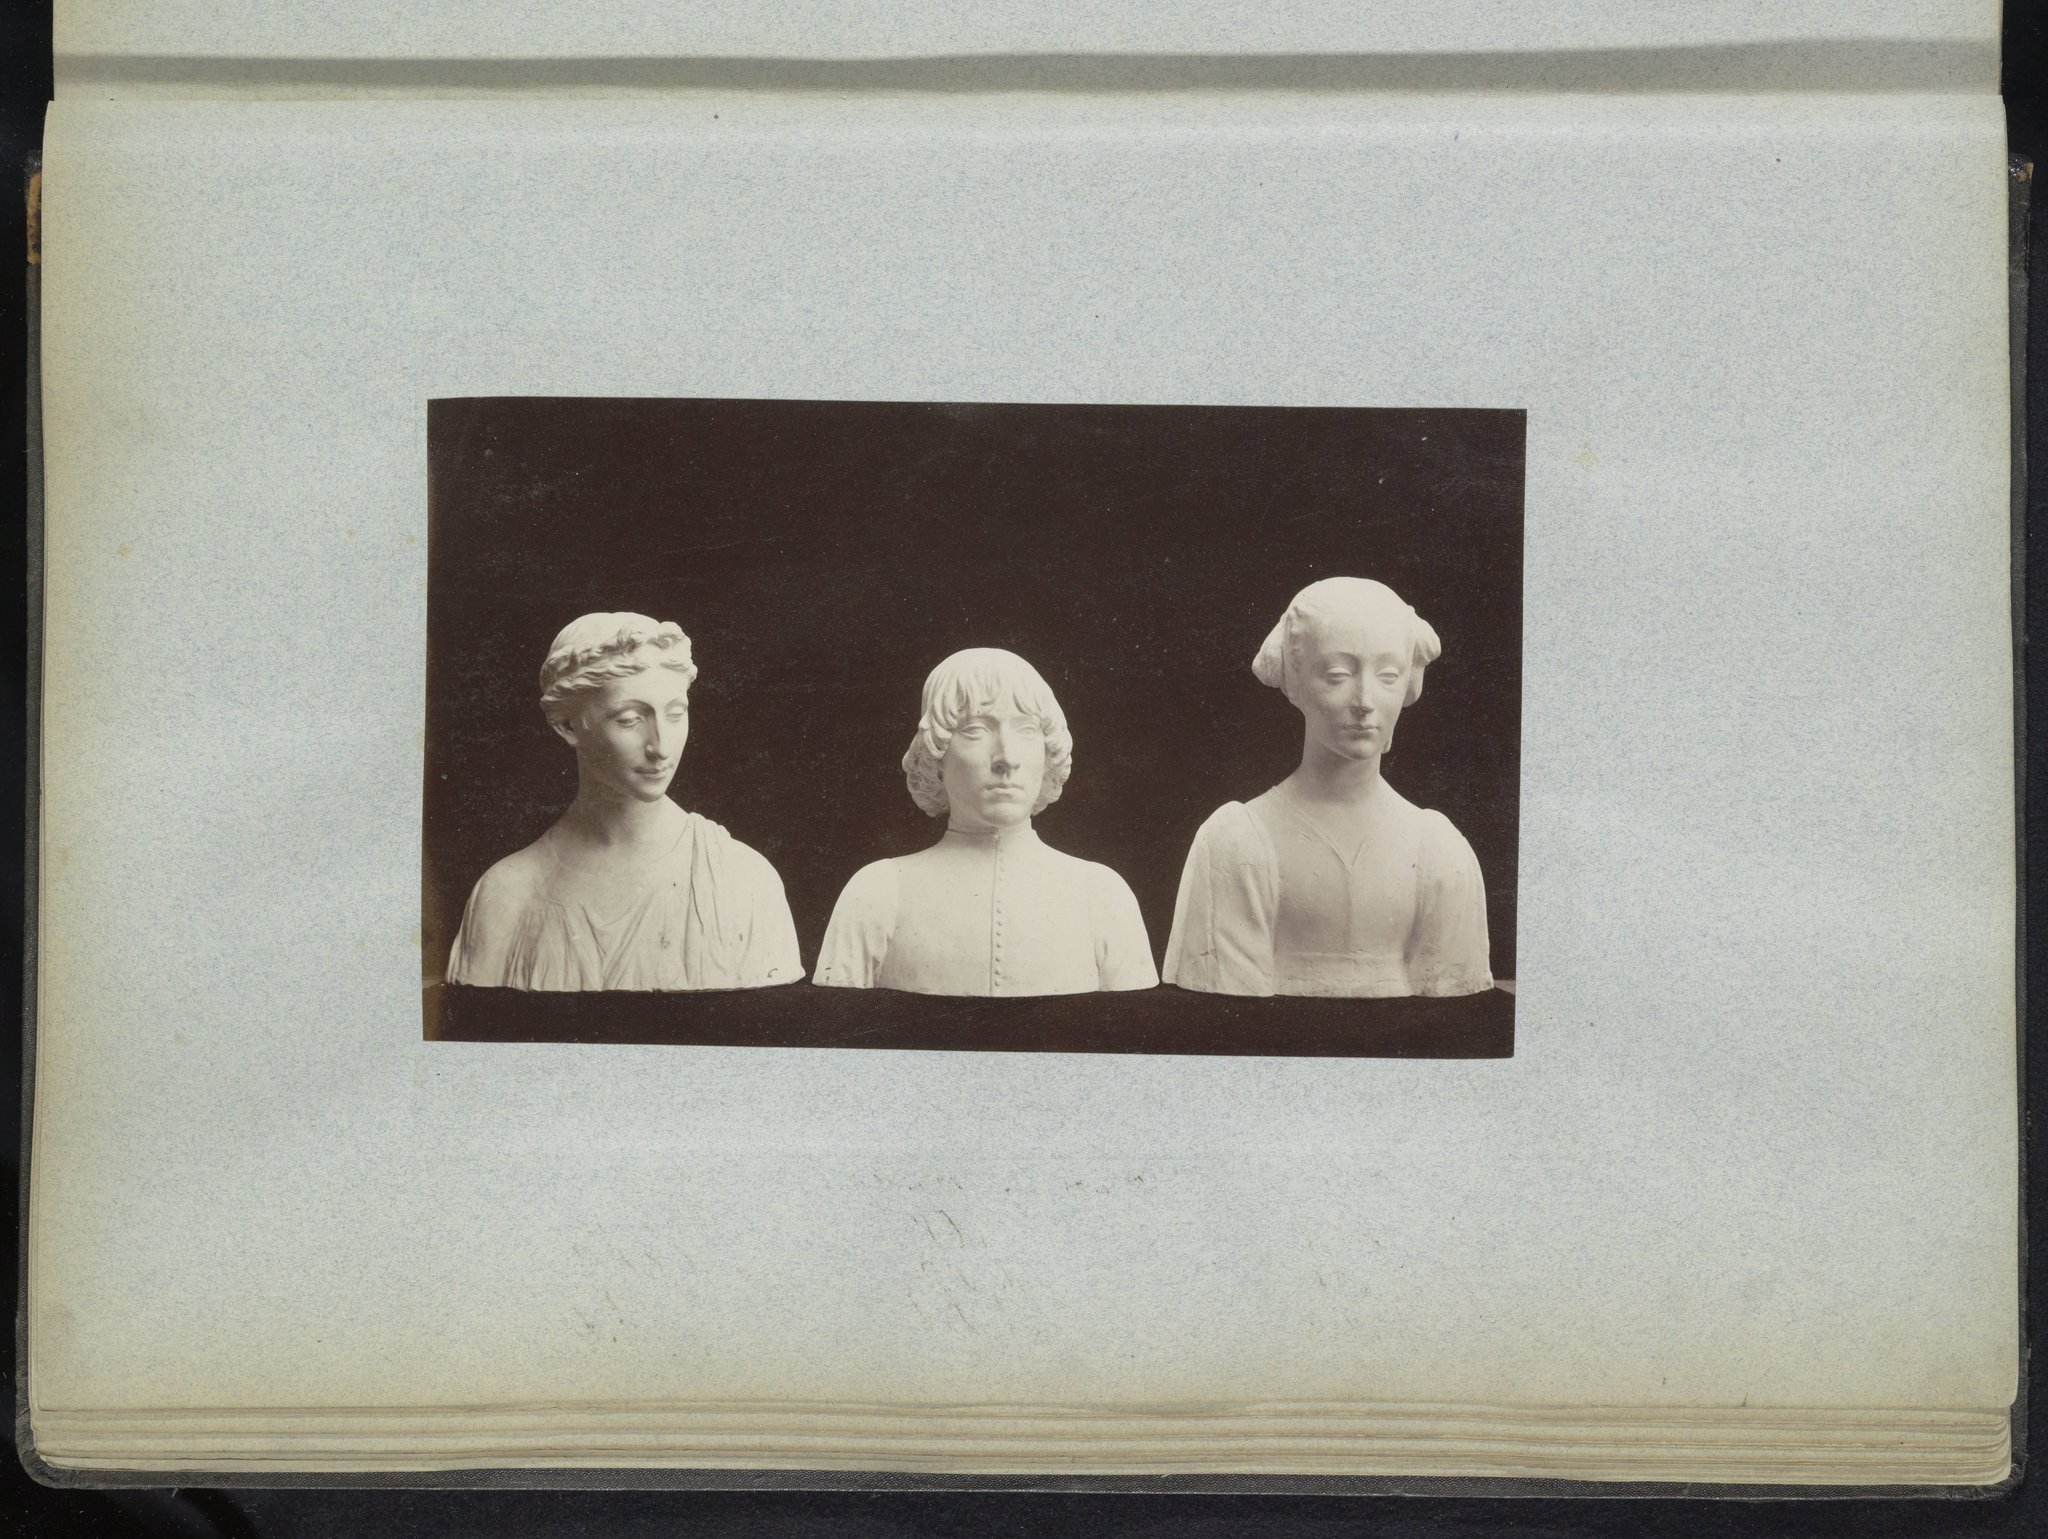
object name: photograph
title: Drie gipsen bustes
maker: Anonymous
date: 1875-1900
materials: paper, photographic support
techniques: albumen print